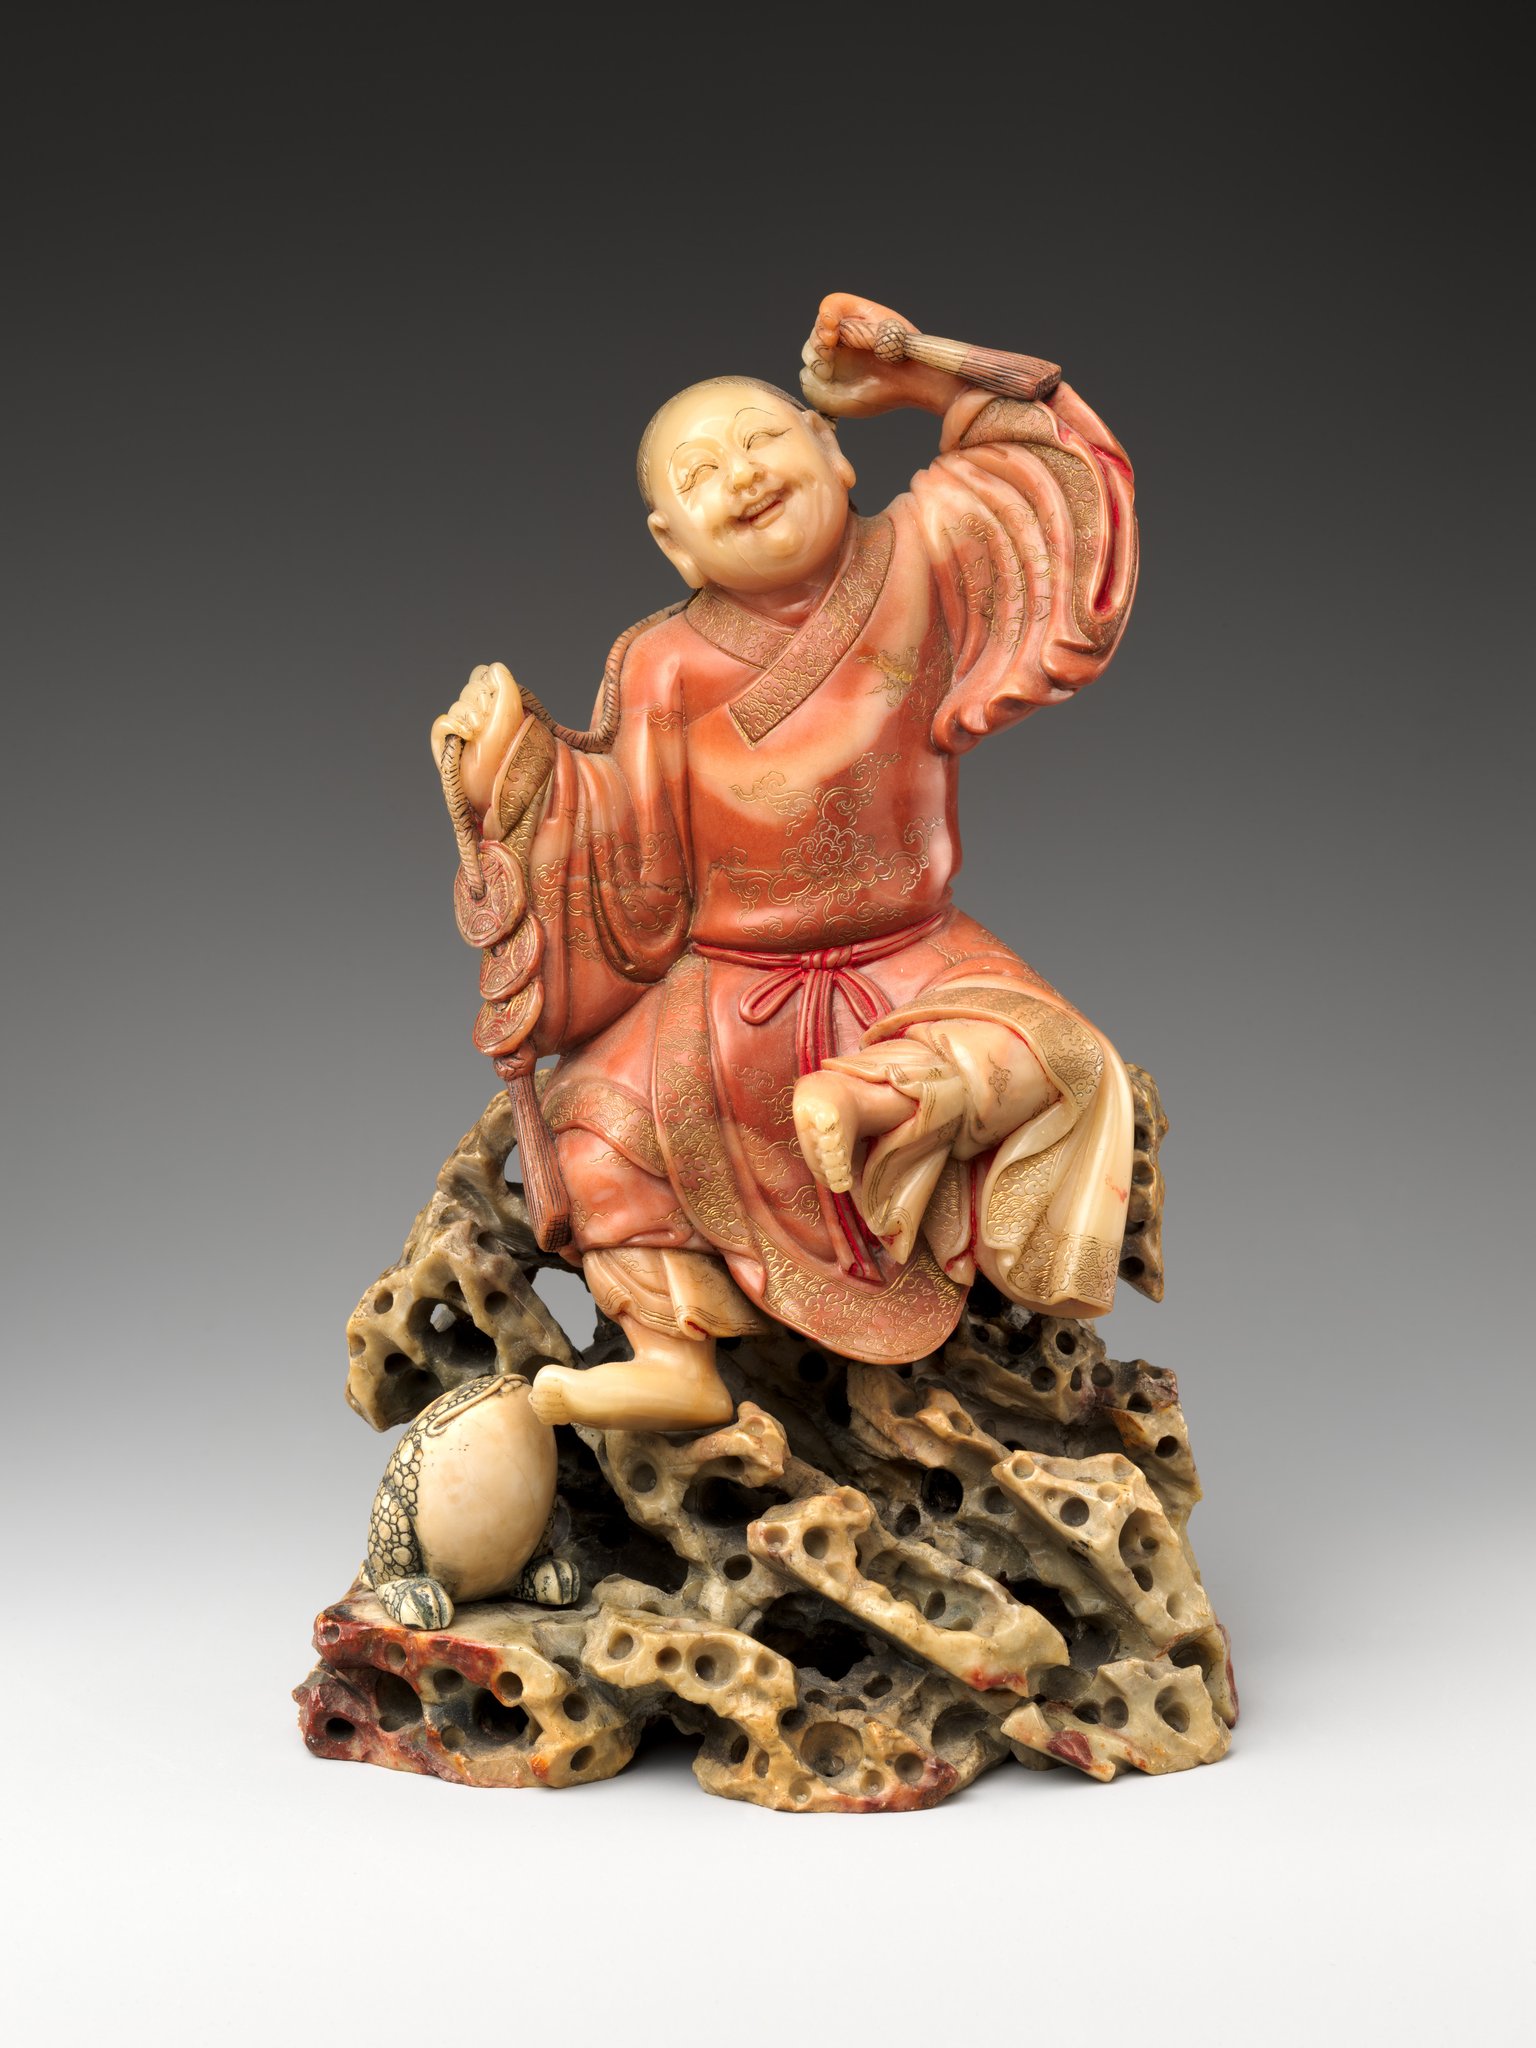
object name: figure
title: Immortal Liu Hai playing with a frog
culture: chinese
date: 1701-1800